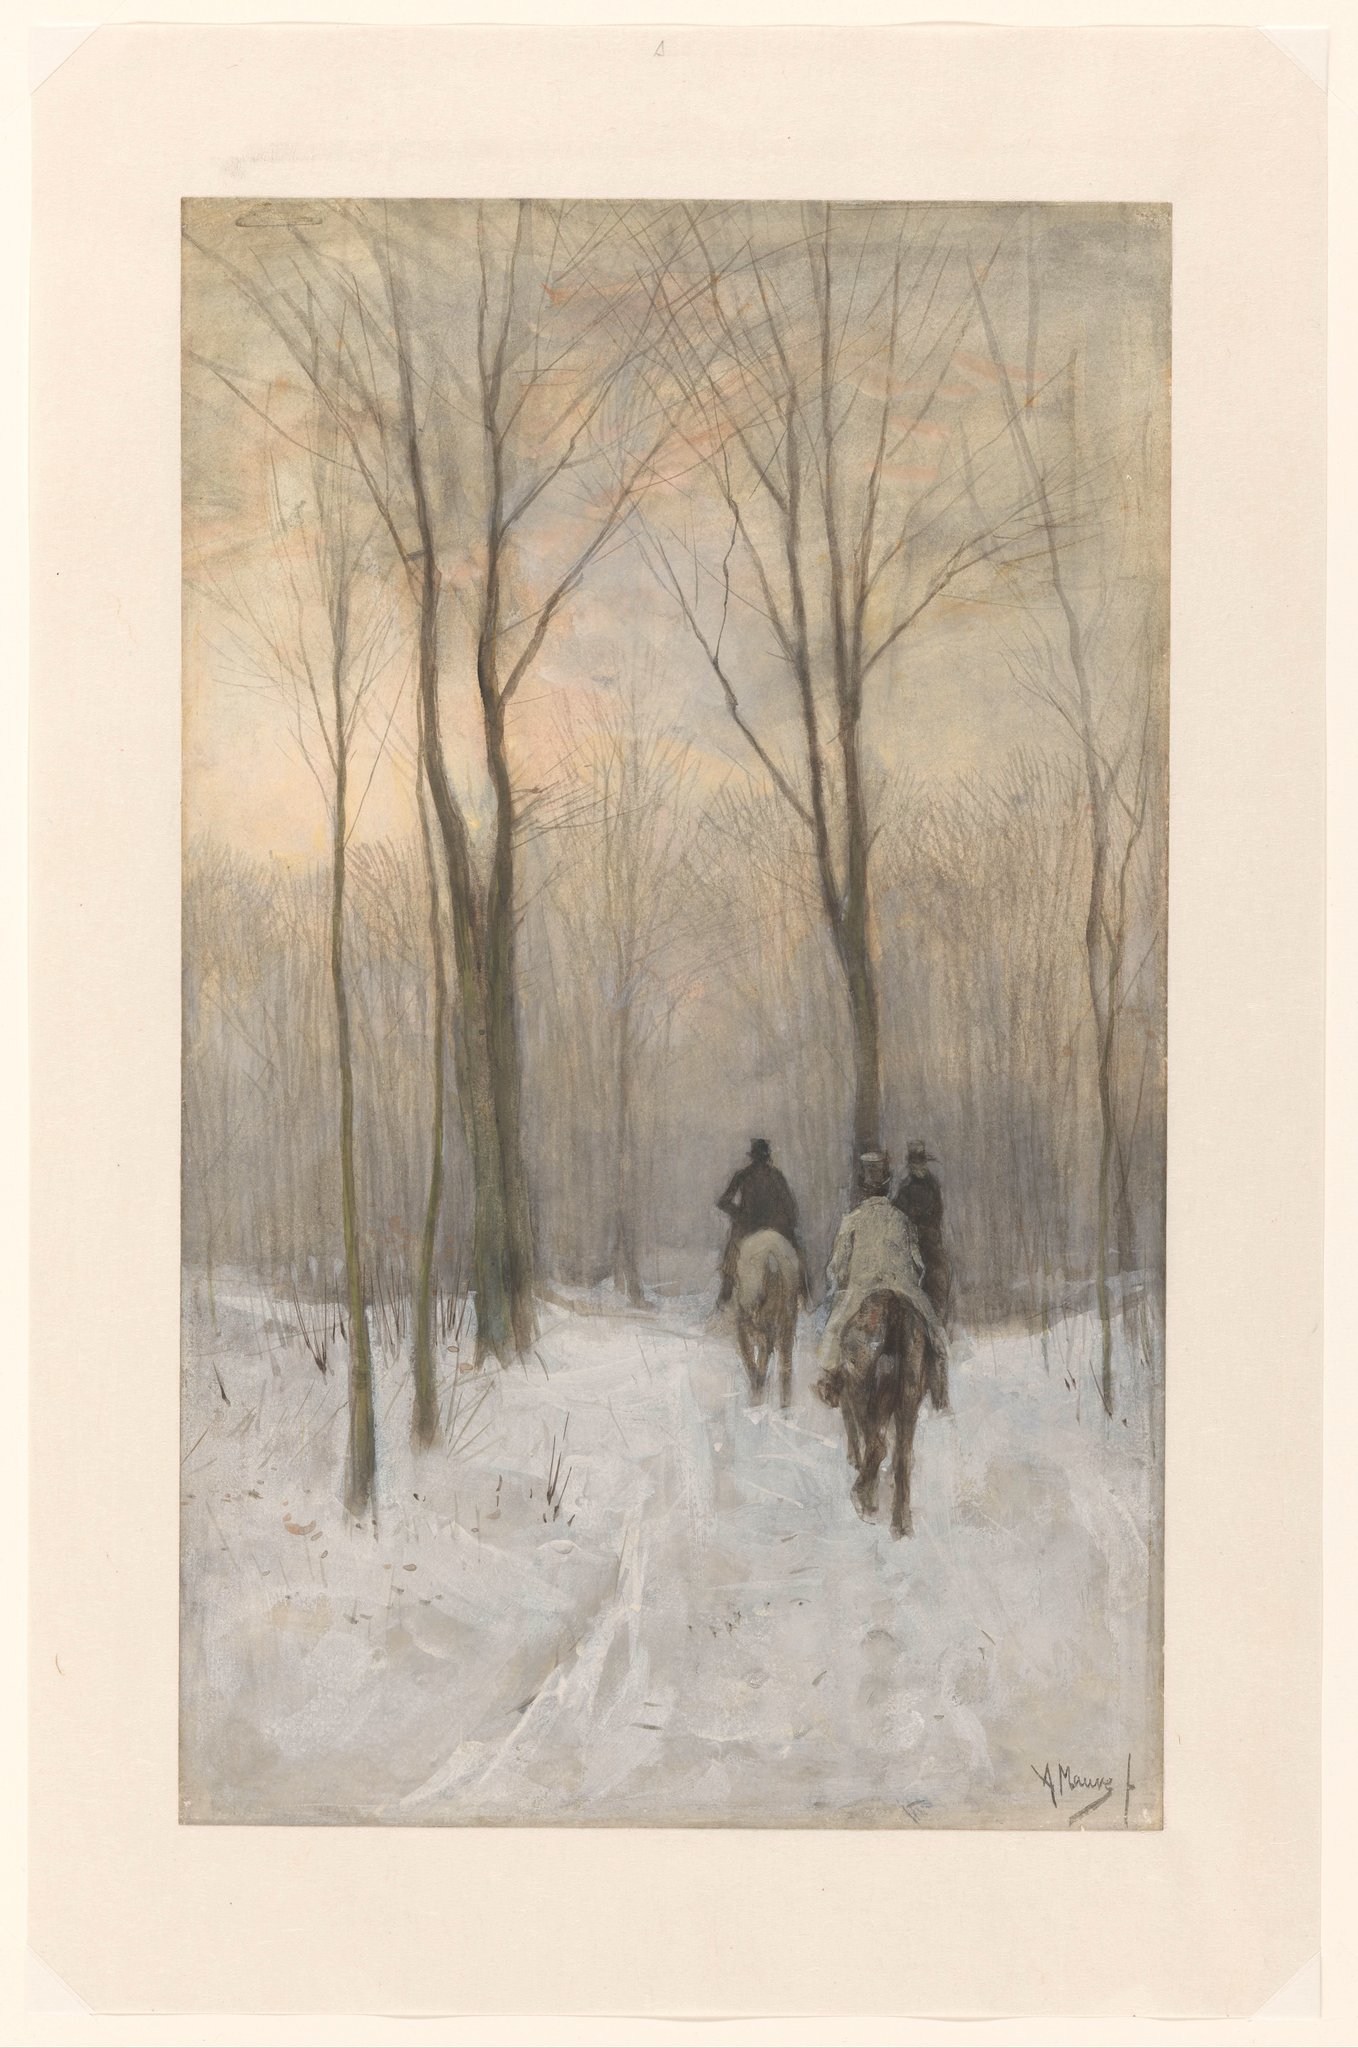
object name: drawing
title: Riders in the Snow in the Haagse Bos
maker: anton mauve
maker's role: draughtsman, painter, print maker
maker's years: 1838-1888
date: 1880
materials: paint, paper, pencil, watercolor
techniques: brush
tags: riding a horse, ass, or mule; rider, horseman, forest, wood, snow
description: As in his painting of the Morning Ride on the Beach (Gallery 1.18), Mauve shows the riders from behind. They are trotting away from the viewer in that silent wood. In the watercolour, the bare branches contrast sharply with the misty background, lit by an almost imperceptible winter sun. The whole scene seems to convey a sense of tranquillity and serenity.